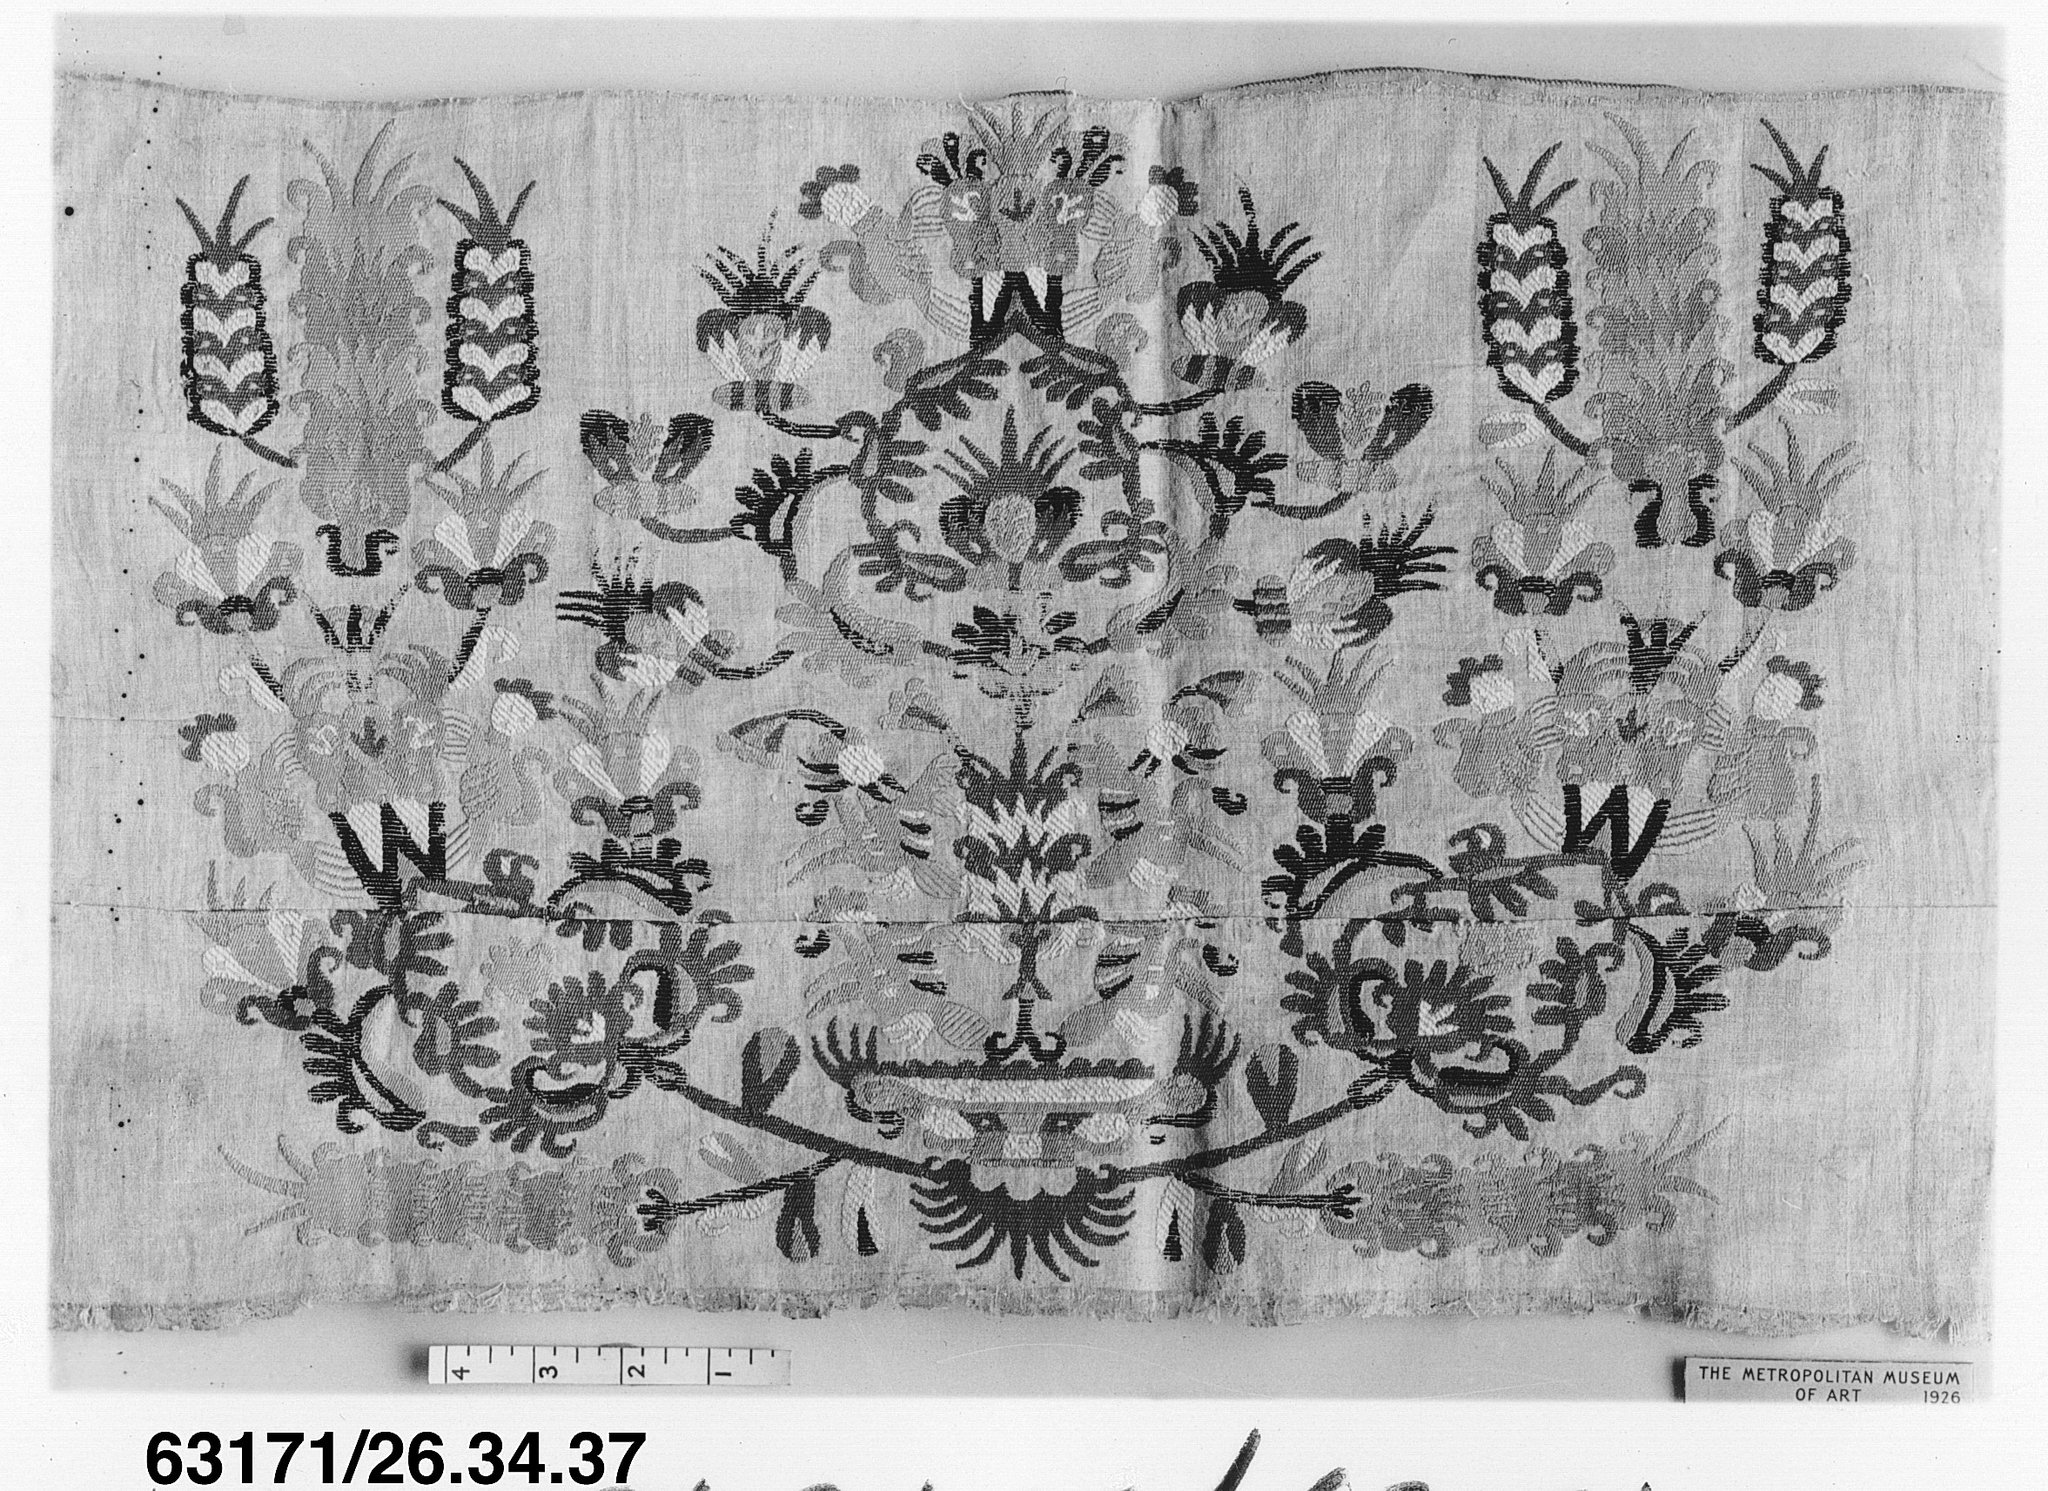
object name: fragment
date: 1701-1800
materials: linen, silk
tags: flowers,leaves